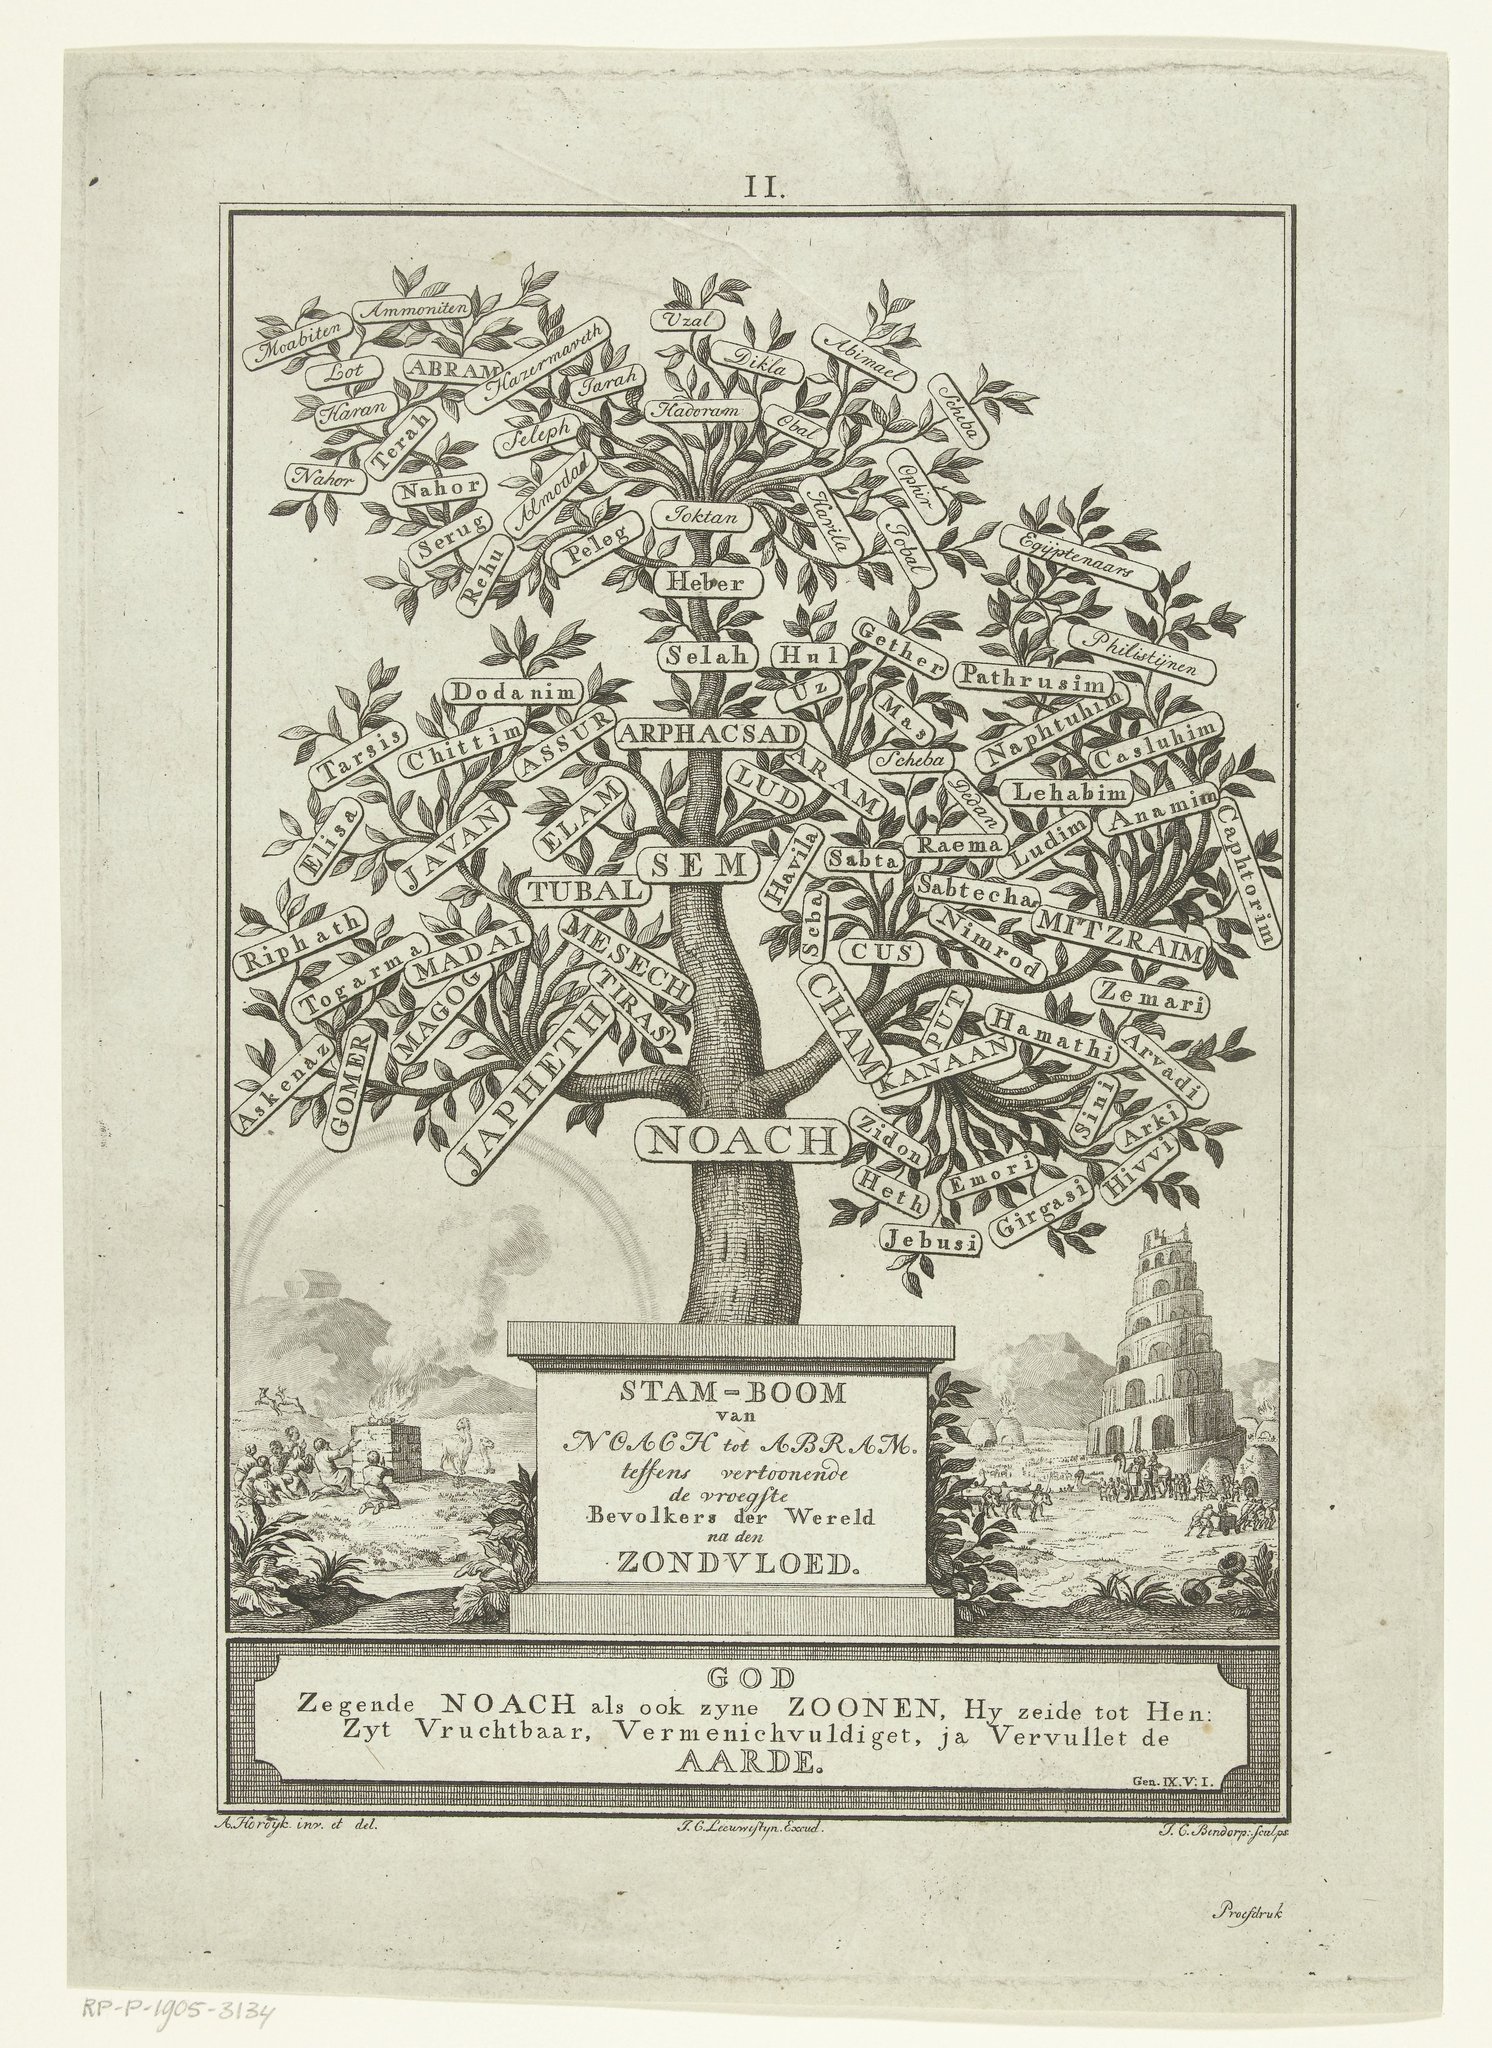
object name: print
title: Stamboom van geslachten van Noach tot Abraham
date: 1776-1849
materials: paper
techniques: etching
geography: netherlands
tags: story of noah, genesis from the descendants of cain and seth to abraham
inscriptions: collector's mark: Lugt 2228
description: Stamboom met de namen van de geslachten van Noach tot Abraham staat op een voetstuk. Ook de namen van andere volkeren worden vermeld. Twee kleine scènes links en rechts verwijzen naar bijbelverhalen: Noach en zijn zonen brengen een offer nadat de Ark gespaard is gebleven voor de Zondvloed en de bouw van de Toren van Babel.